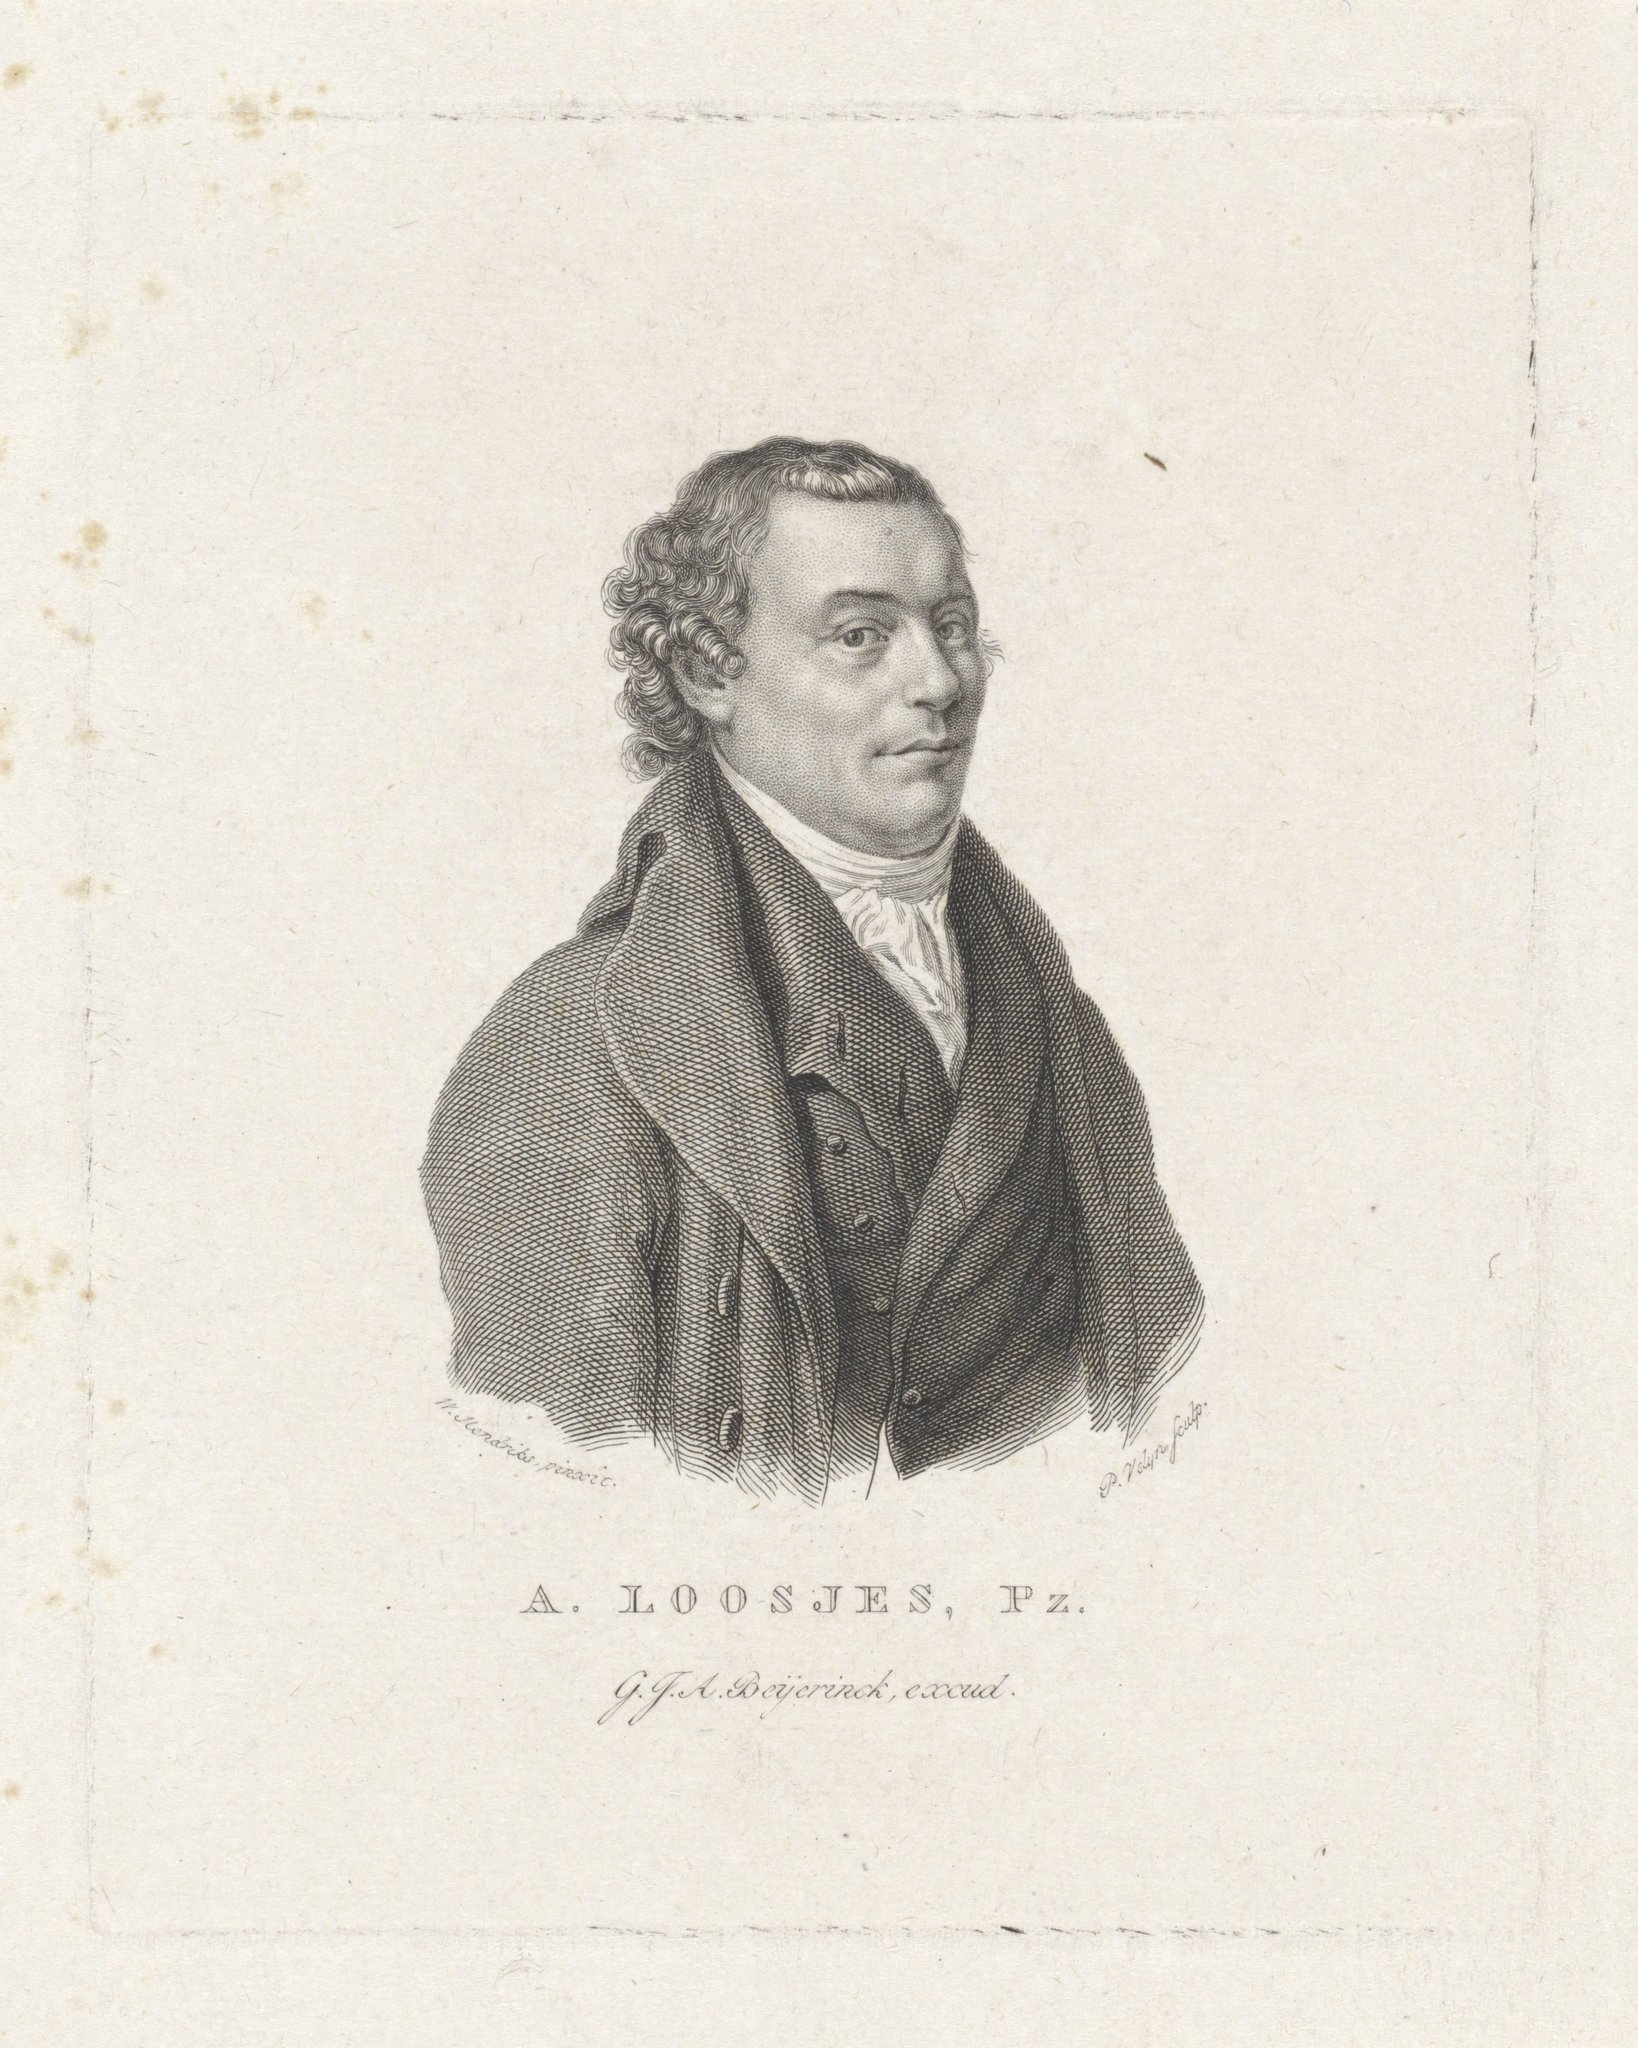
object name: print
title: Portret van Adriaan Pietersz. Loosjes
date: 1797-1836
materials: paper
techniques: engraving, etching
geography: netherlands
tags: haarlem, publisher, bookseller, adriaan pietersz. loosjes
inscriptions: collector's mark: Lugt 2228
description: Portret van Adriaan Pietersz. Loosjes, uitgever en boekverkoper te Haarlem.